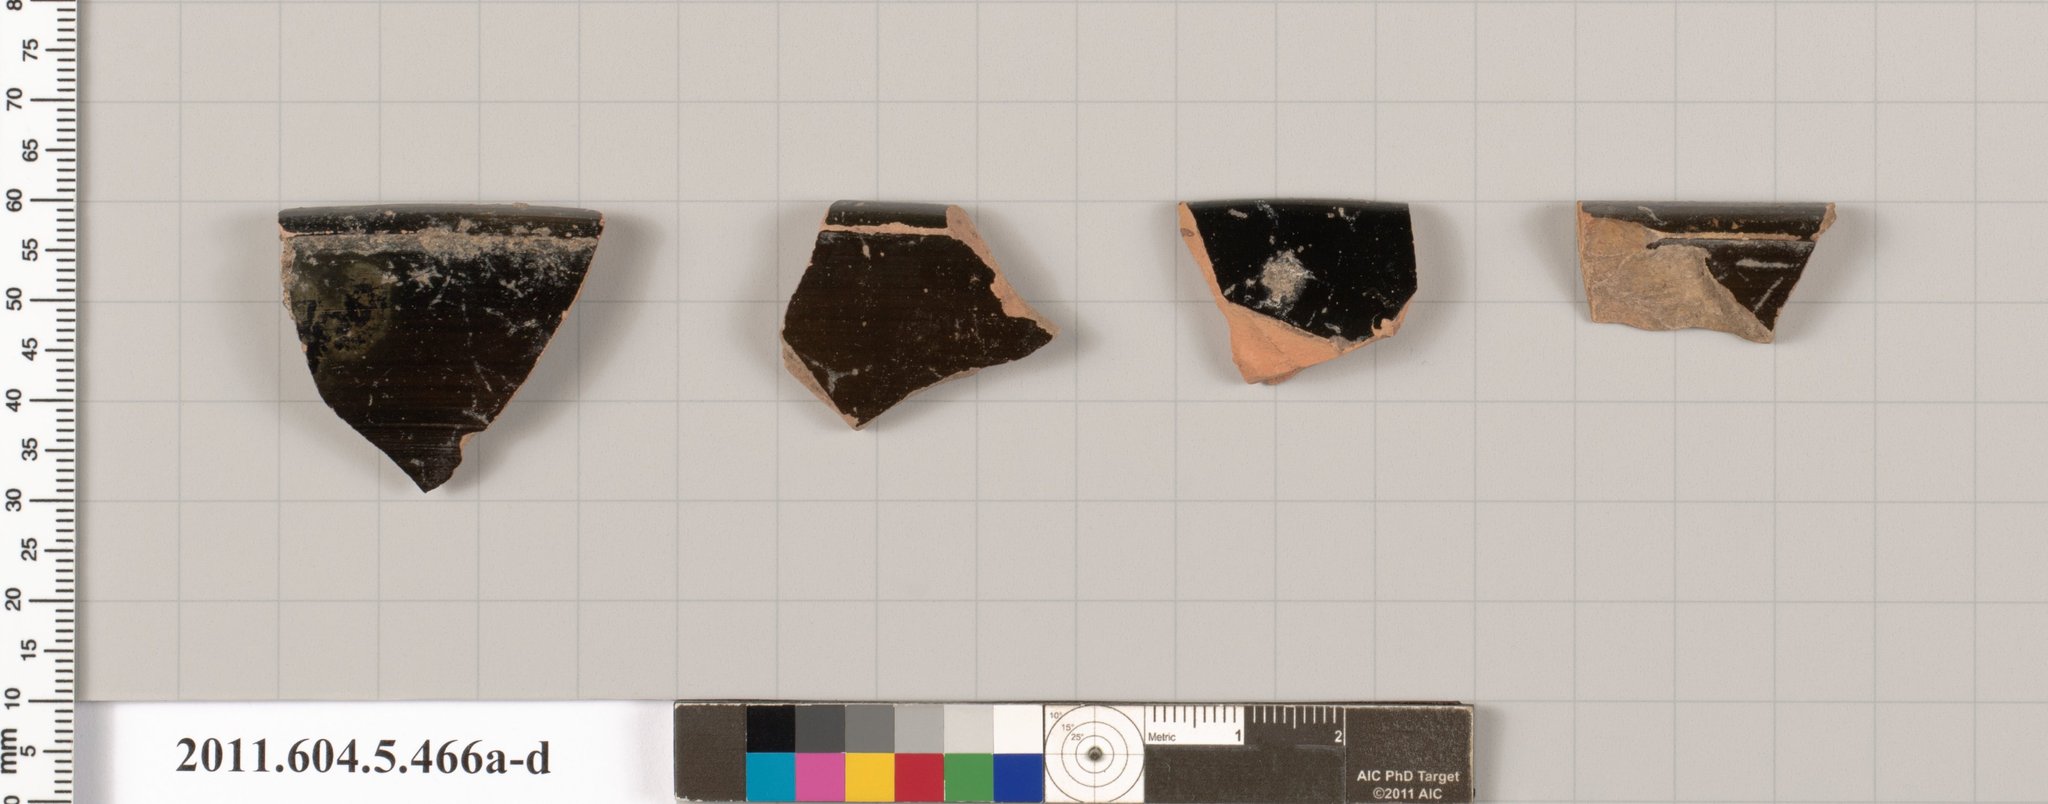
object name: kylix fragment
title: Terracotta rim fragments of kylikes (drinking cups)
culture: greek, attic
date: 600-401 BCE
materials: terracotta